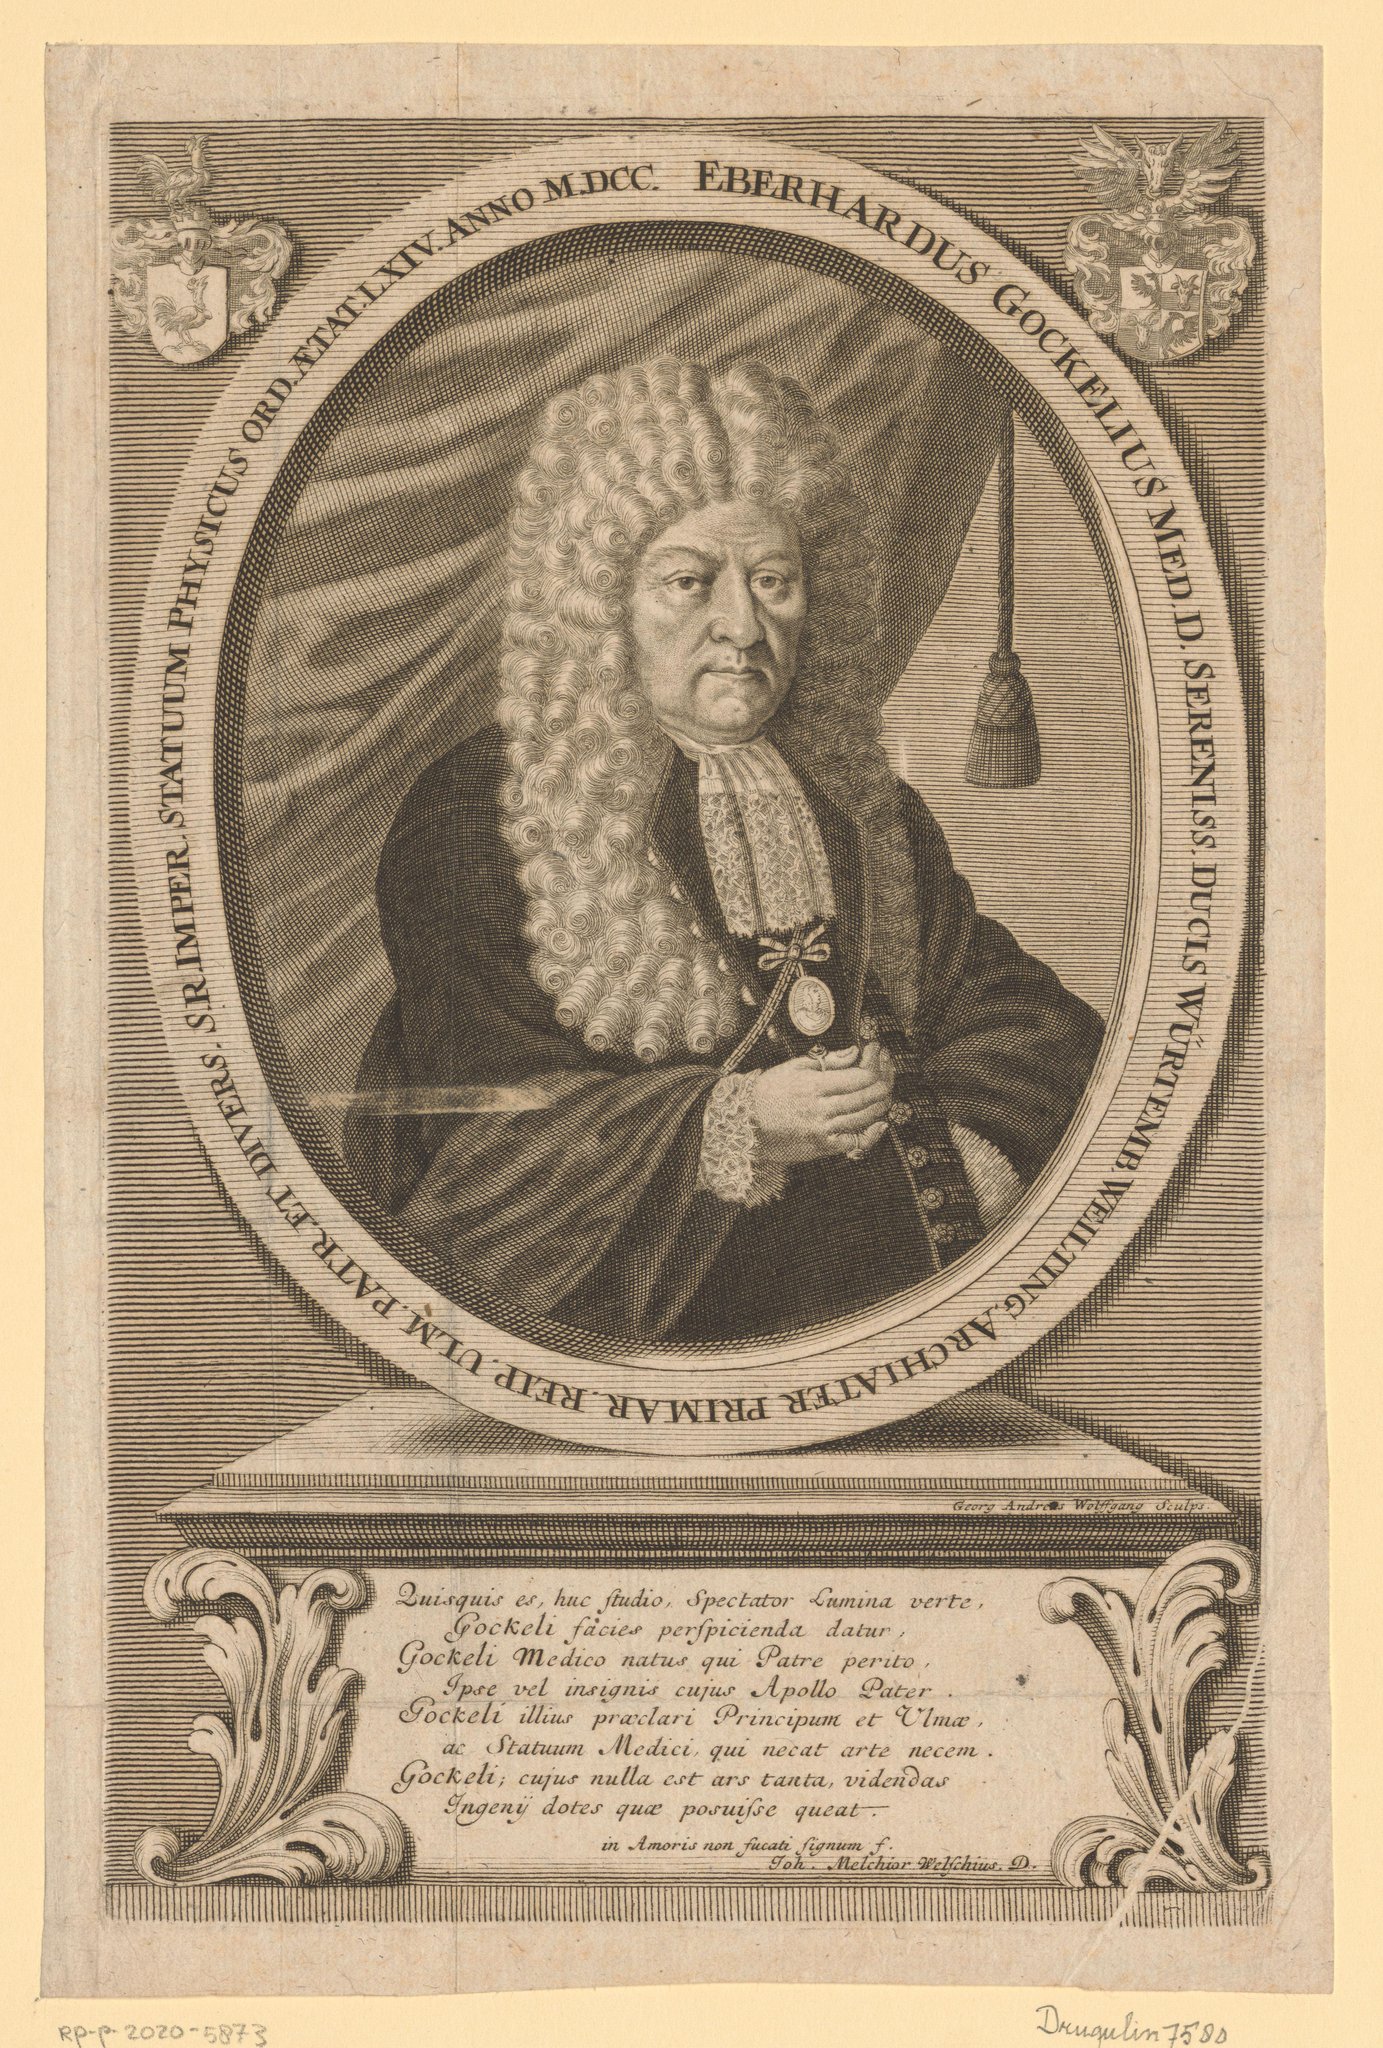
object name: print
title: Portret van Eberhard Gockel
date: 1670-1716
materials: paper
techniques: engraving, etching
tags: historical persons, physician, doctor